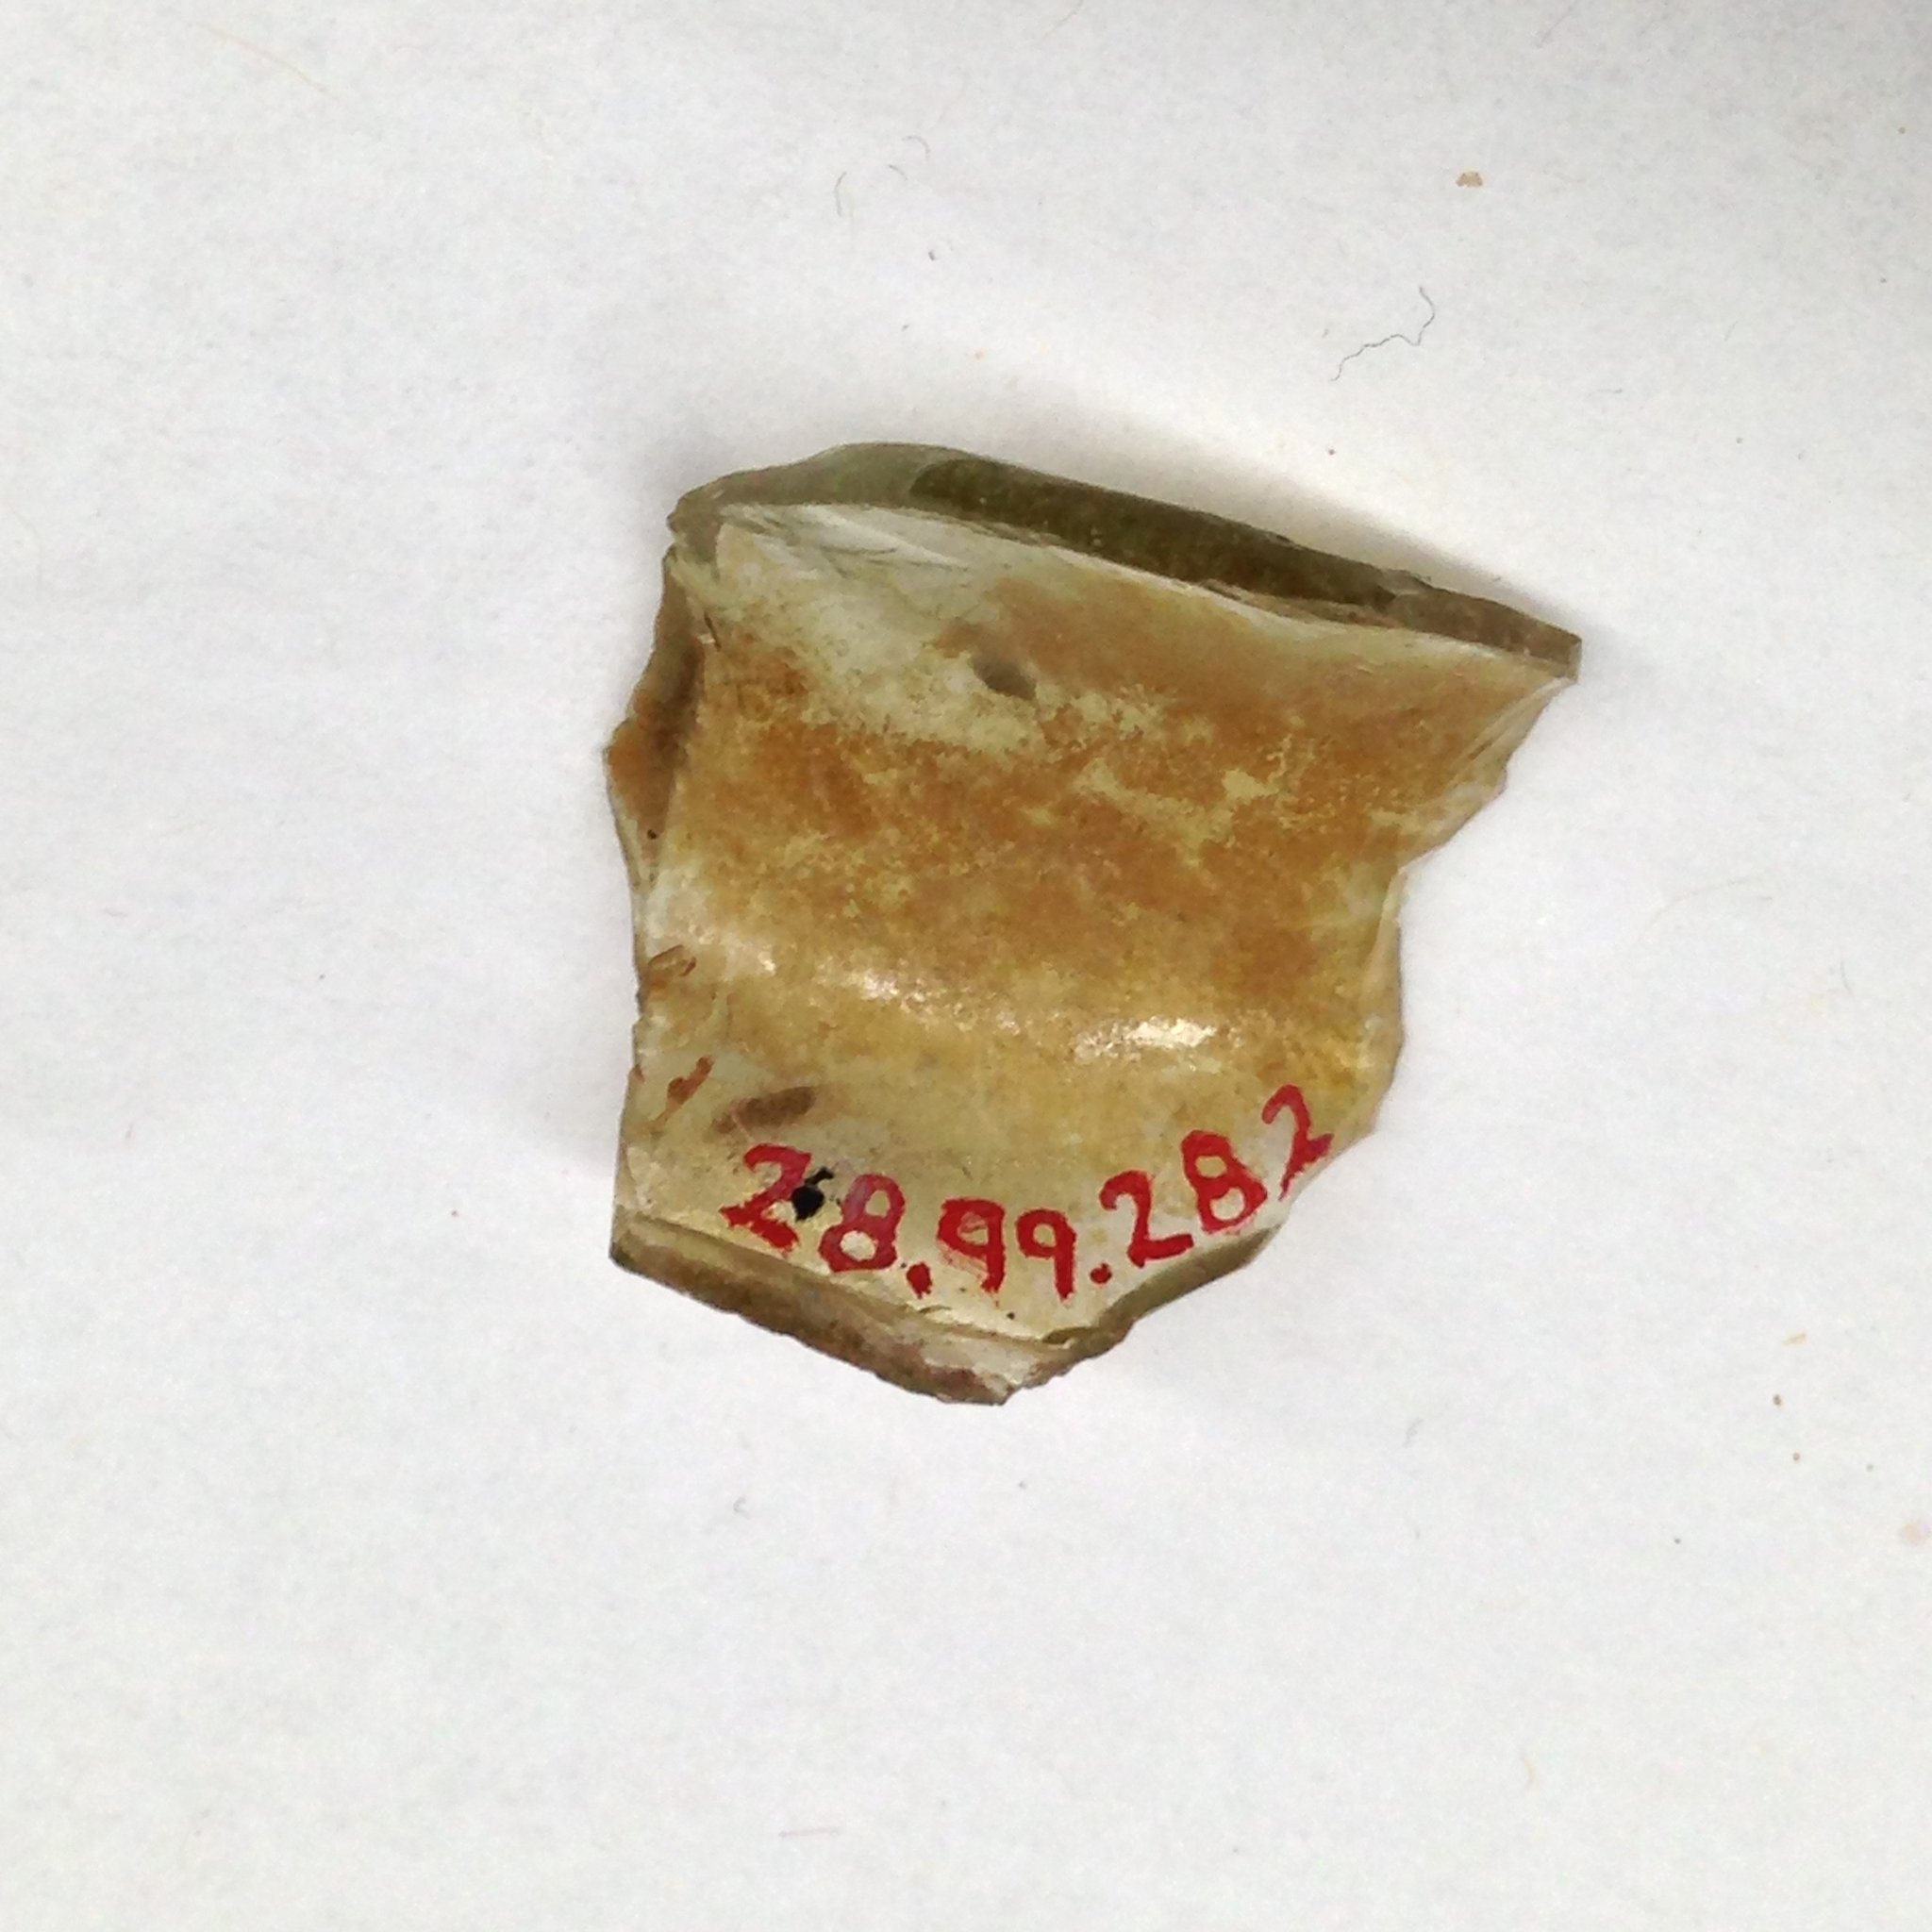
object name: fragment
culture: european or middle eastern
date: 1150-1250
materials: ceramic, glass